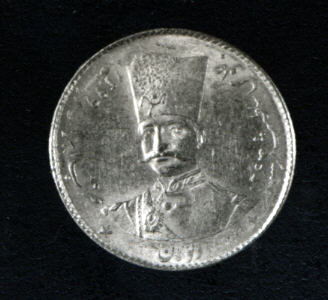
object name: coin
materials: gold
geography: iran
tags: men,portraits